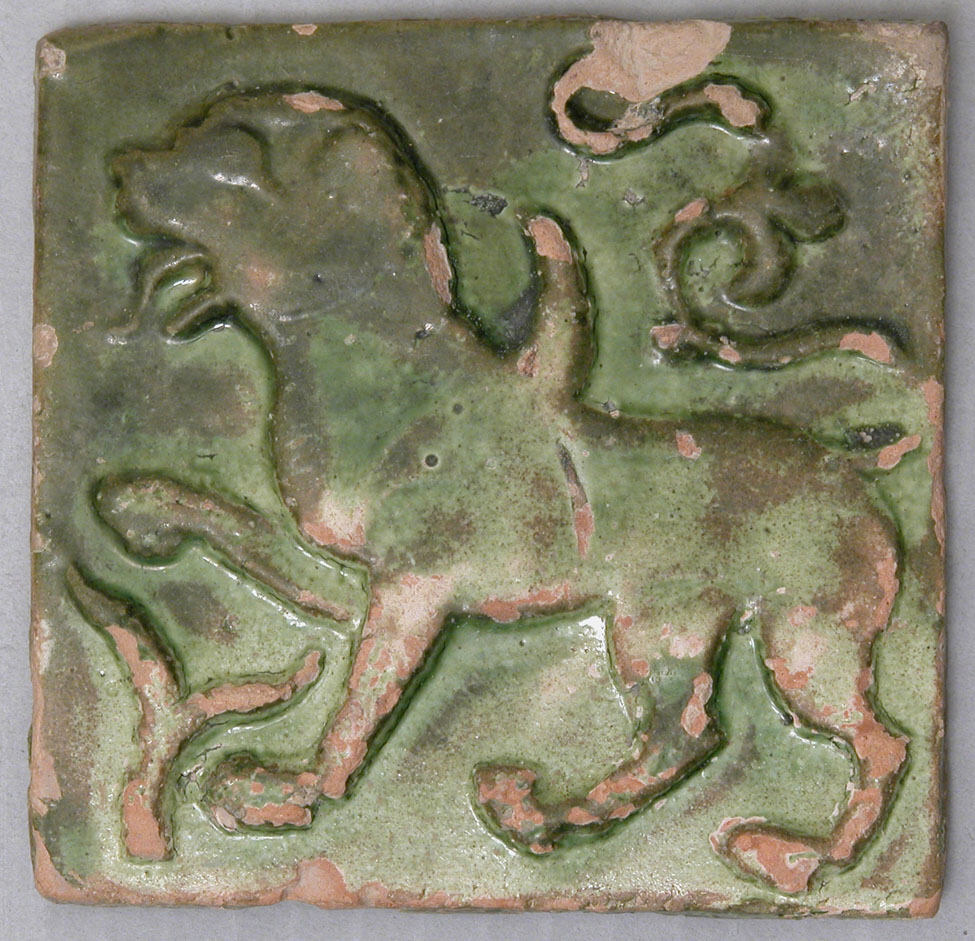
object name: tile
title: Square Tile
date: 1167-1233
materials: earthenware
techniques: glazing, molding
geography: afghanistan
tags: animals